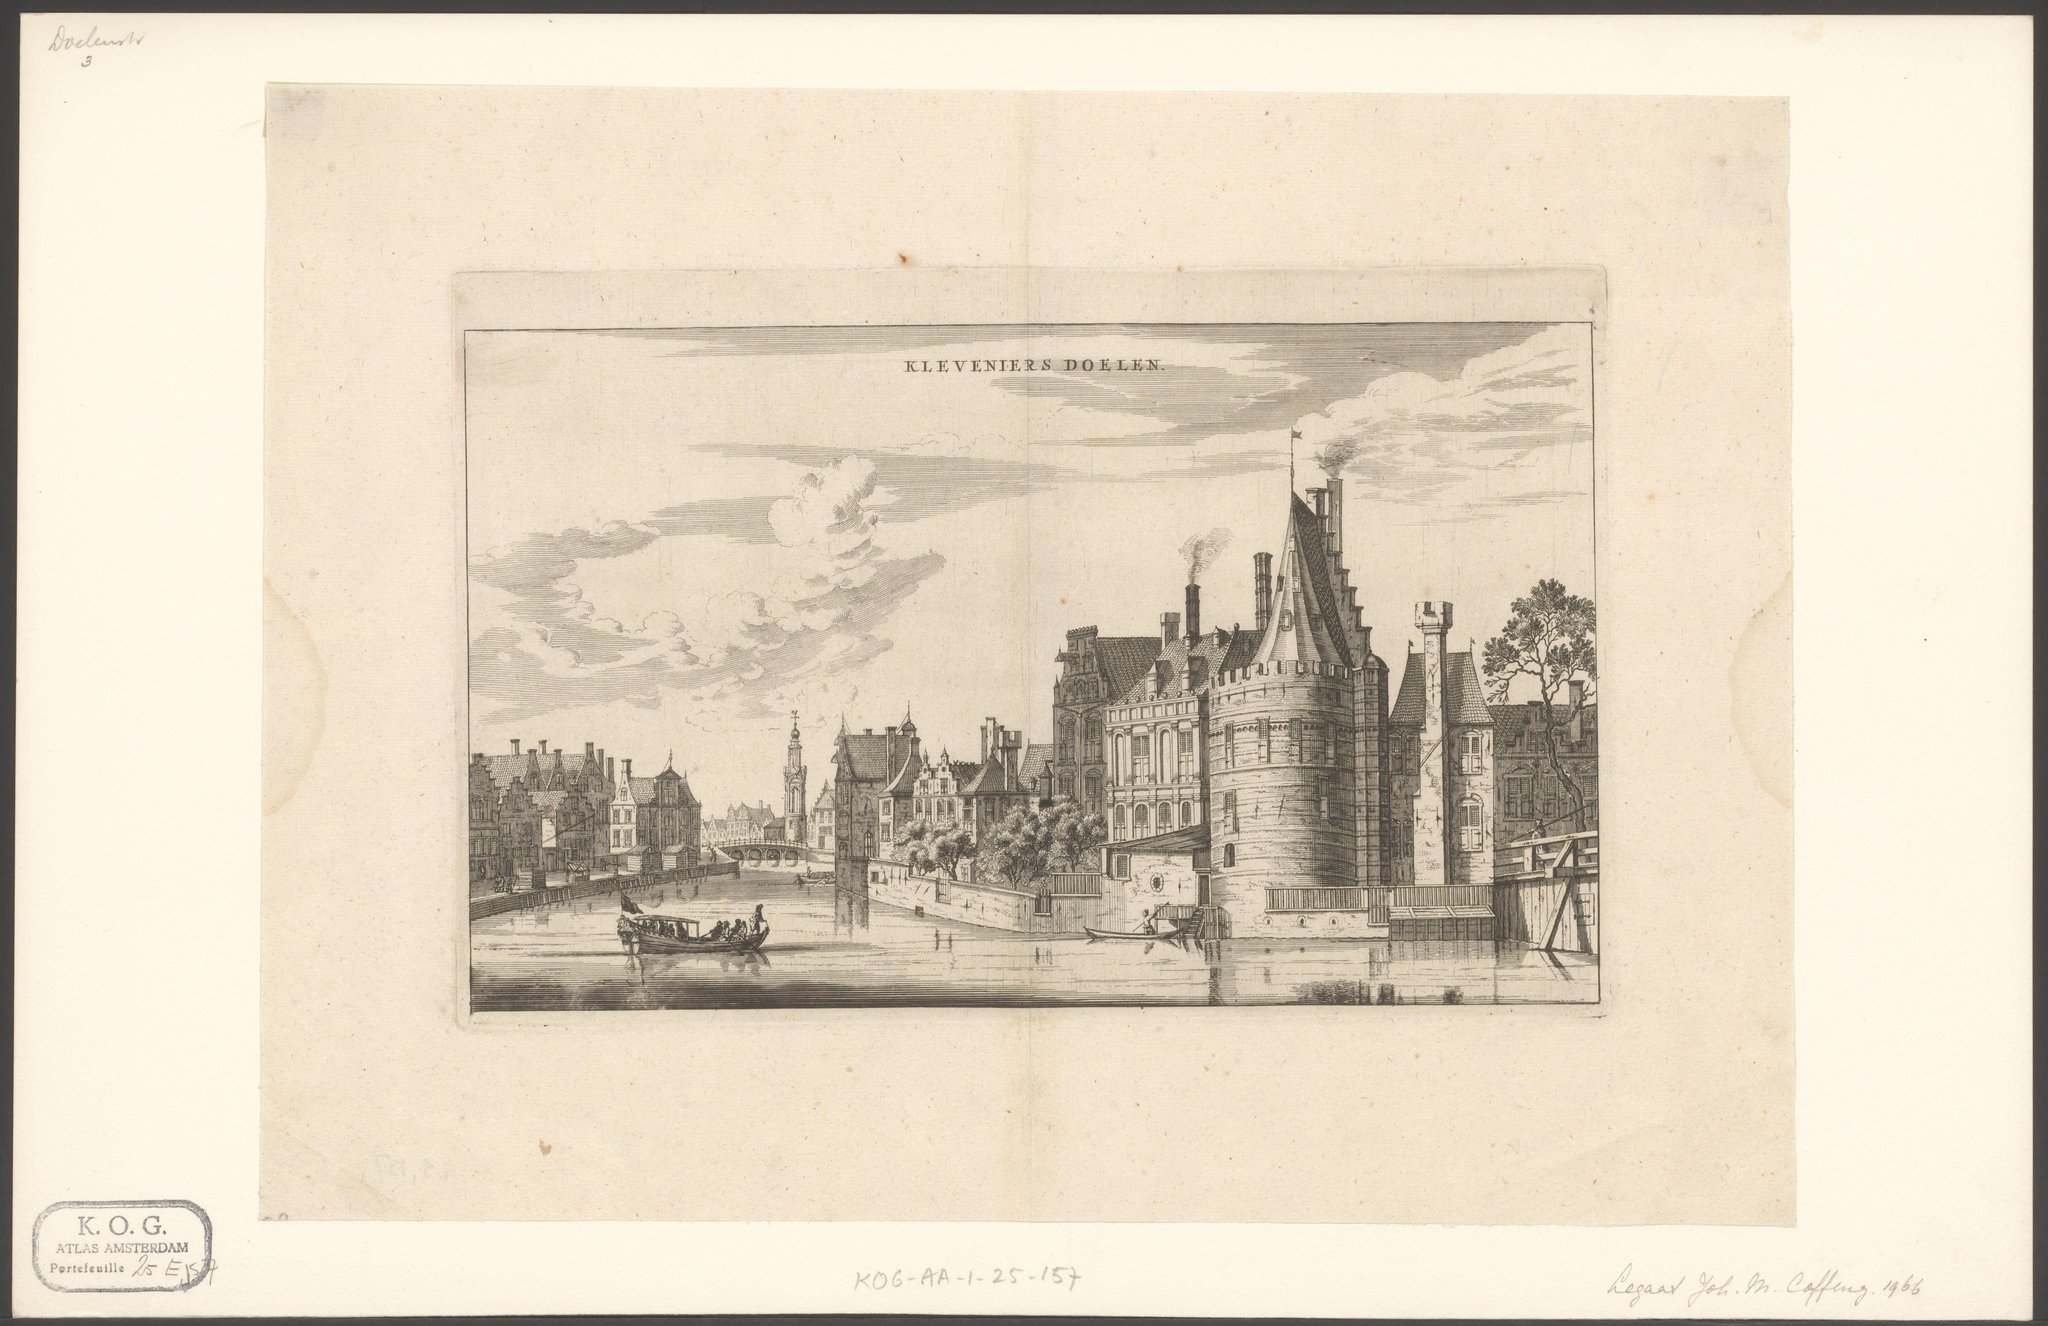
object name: print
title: Kleveniers Doelen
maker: jacob van meurs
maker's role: draughtsman, print maker, publisher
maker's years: 1619-1680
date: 1663-1664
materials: paper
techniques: engraving, etching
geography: amsterdam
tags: towers ~ fortified city, city-walls, land forces (+ citizen soldiery, civil guard, citizen militia), canals, waters (in city) (+ city(-scape) with figures, staffage)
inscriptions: collector's mark: ‘25E.157’ Lugt 1641b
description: Huidige staat van prent ook gebruikt in: Dapper, Olfert. Historische beschryving der stadt Amsterdam: waer in de voornaemste geschiedenissen (na een kort verhael van gansch Hollant en d'omleggende dorpen (…). Amsterdam: Jacob van Meurs, 1663.* En in: Zesen, Philipp von. Beschreibung der Stadt Amsterdam: darinnen von derselben ersten Ursprunge bis auf gegenwärtigen Zustand (…). Amsterdam: Joachim Nosche, 1664. * In sommige exemplaren van deze uitgave komt de huidige staat van de prent voor. In andere exemplaren is een latere staat ingebonden, waarop boven de Nederlandse een Franse titel is toegevoegd.